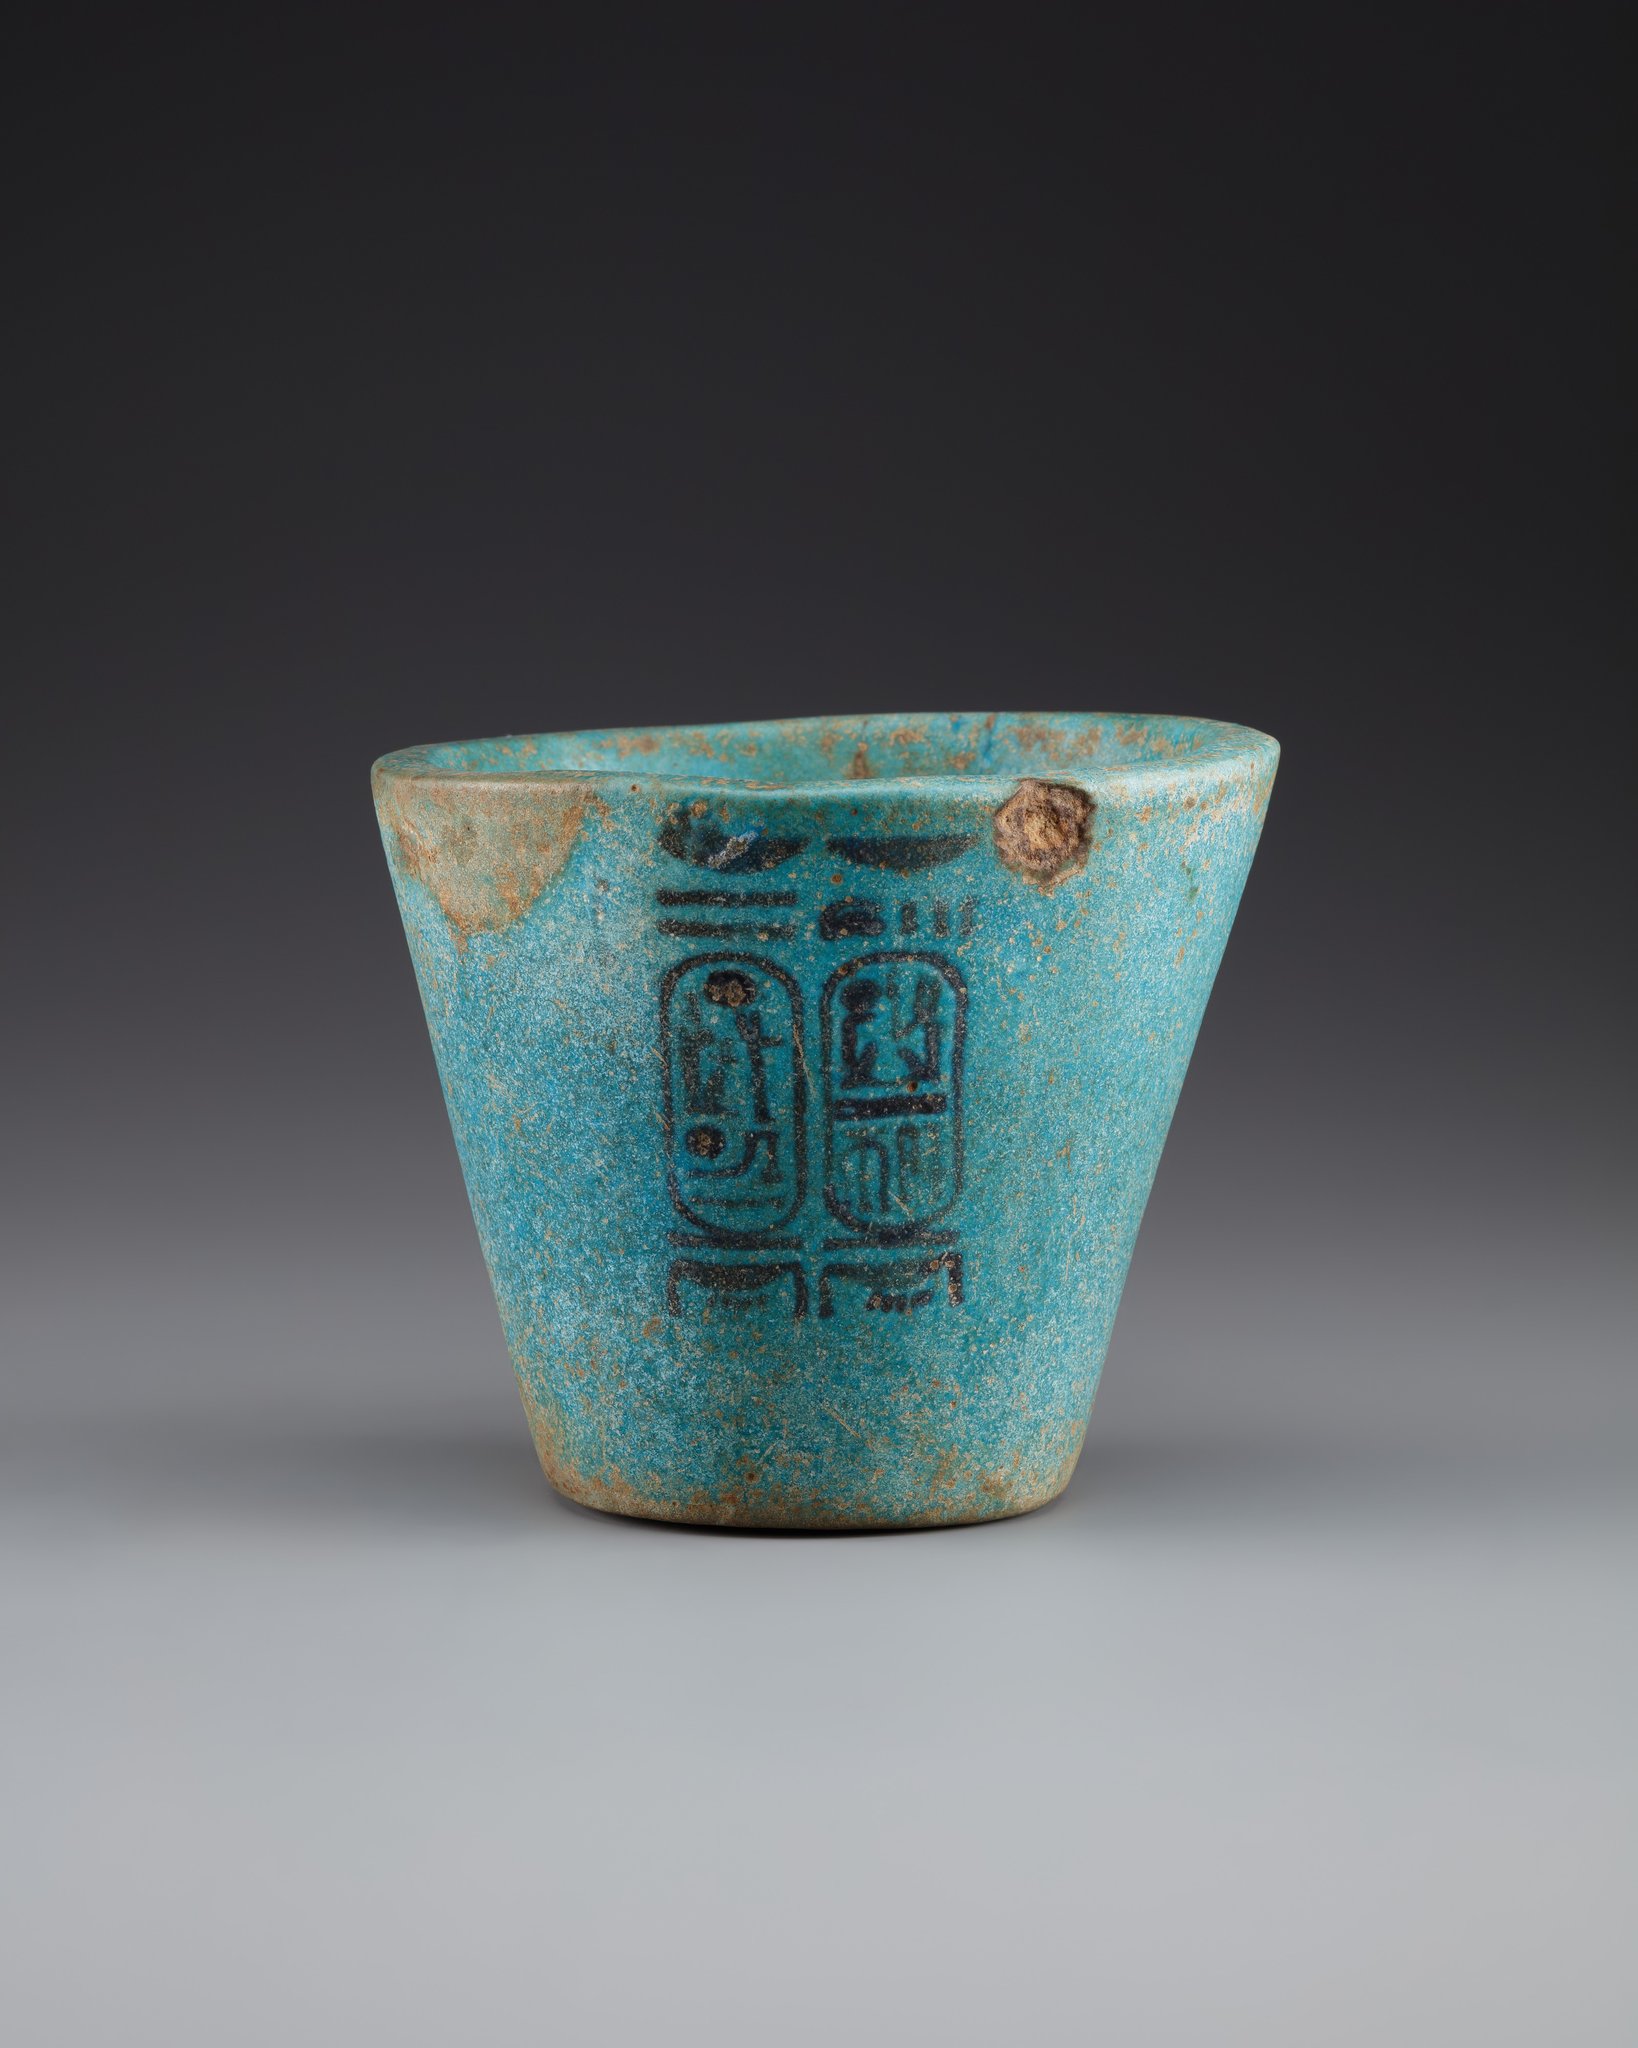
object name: cup, ramesses ii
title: Cup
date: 1279-1213 BCE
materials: faience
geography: egypt